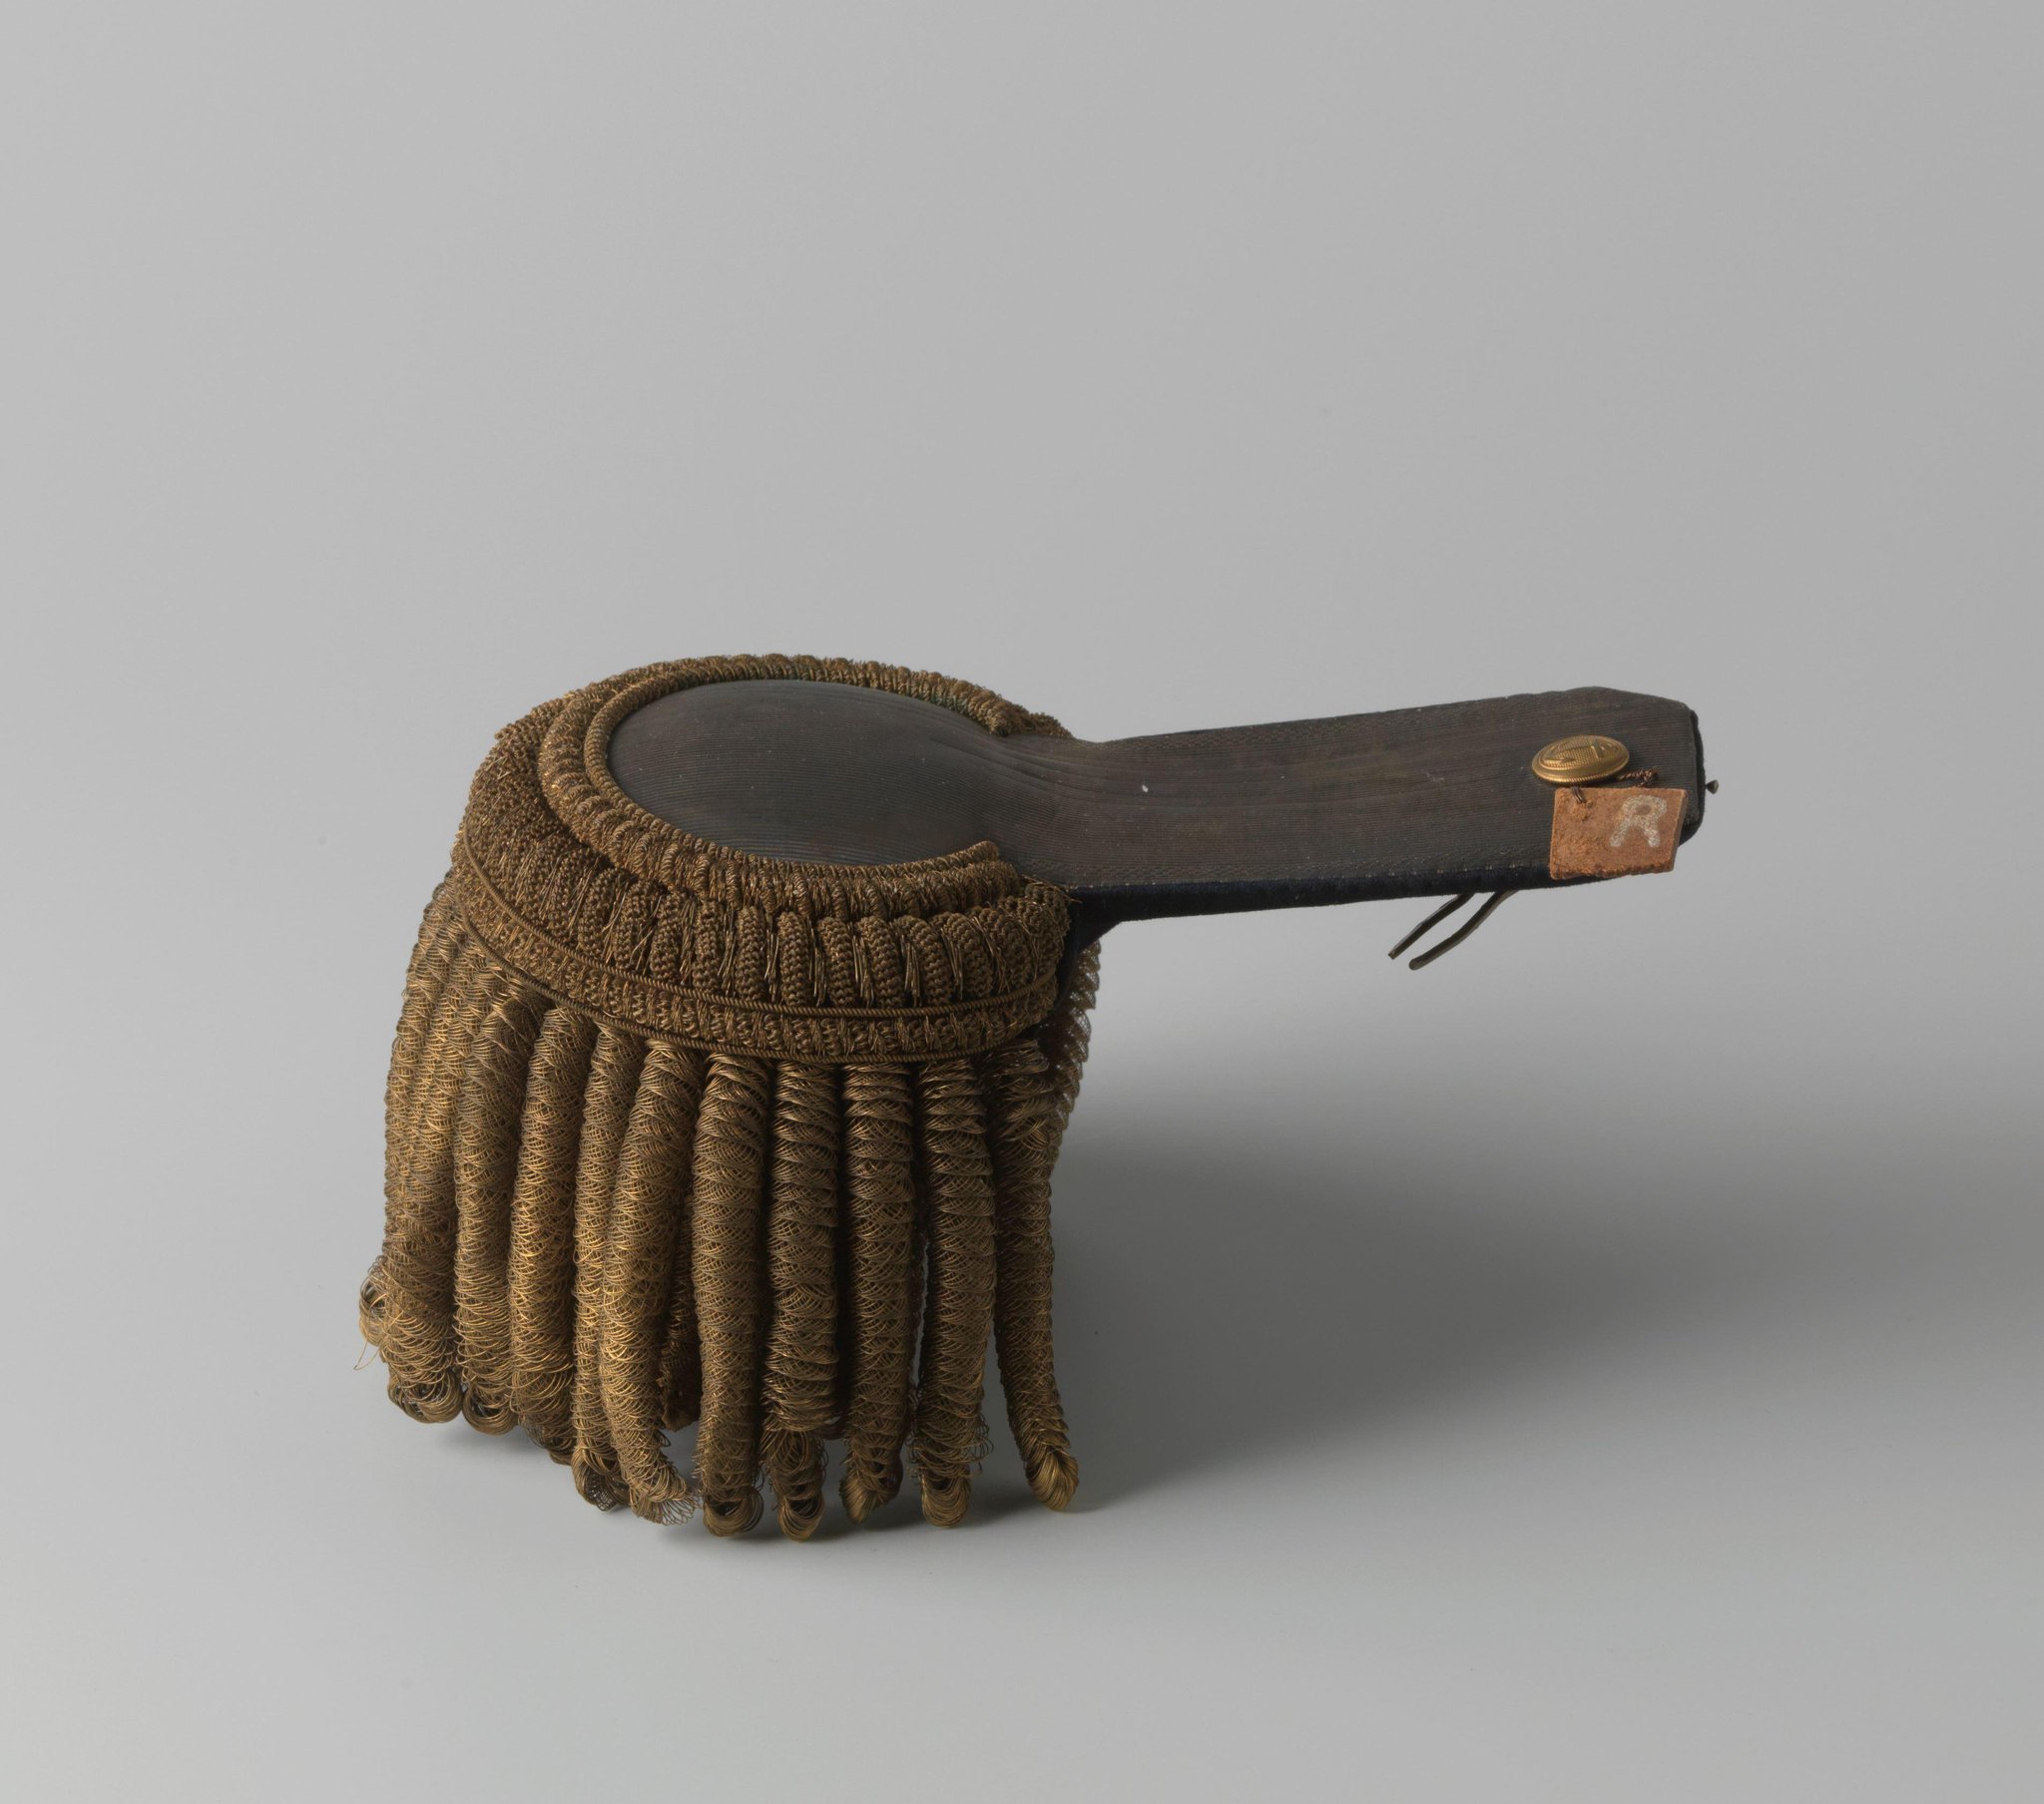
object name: epaulet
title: Eén marine-epaulet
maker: Anonymous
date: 1800-1830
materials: gold, gold thread, leather, wool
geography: netherlands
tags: belgium